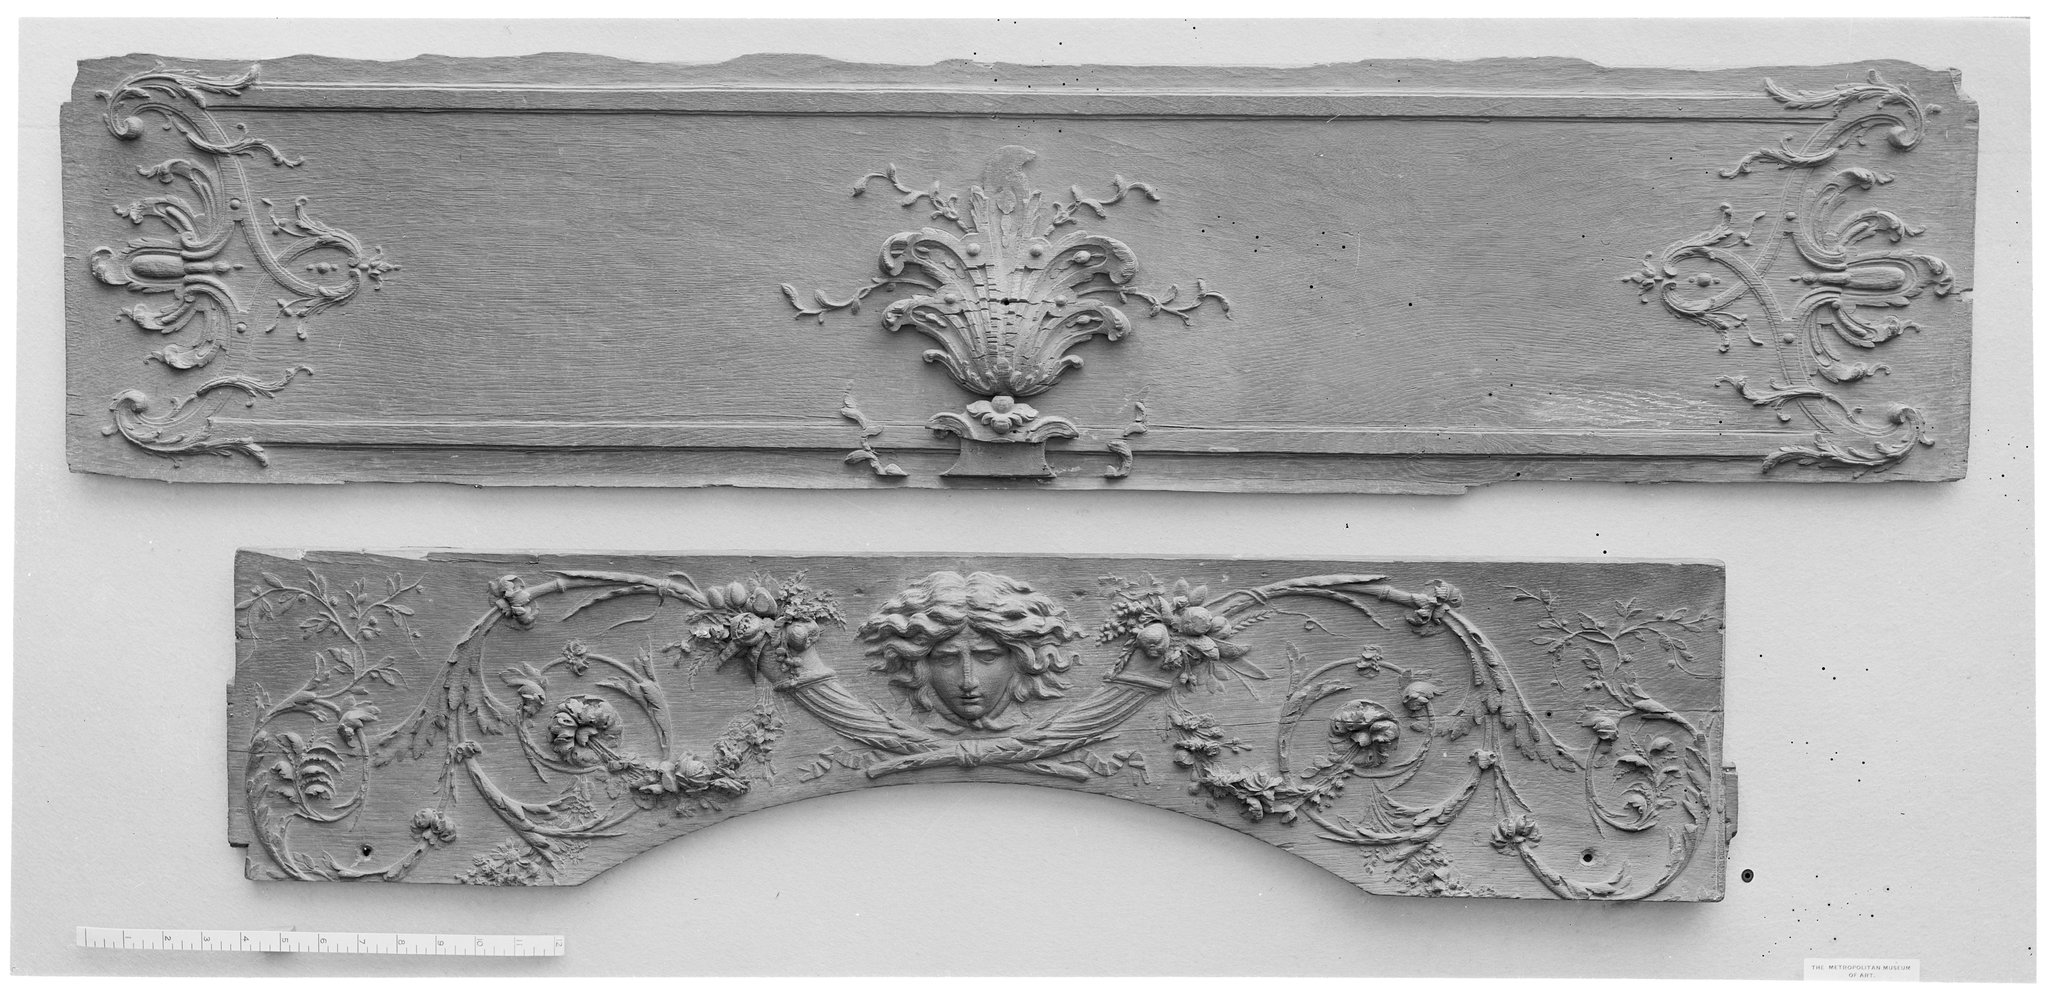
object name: panel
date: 1701-1733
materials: wood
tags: faces,flowers